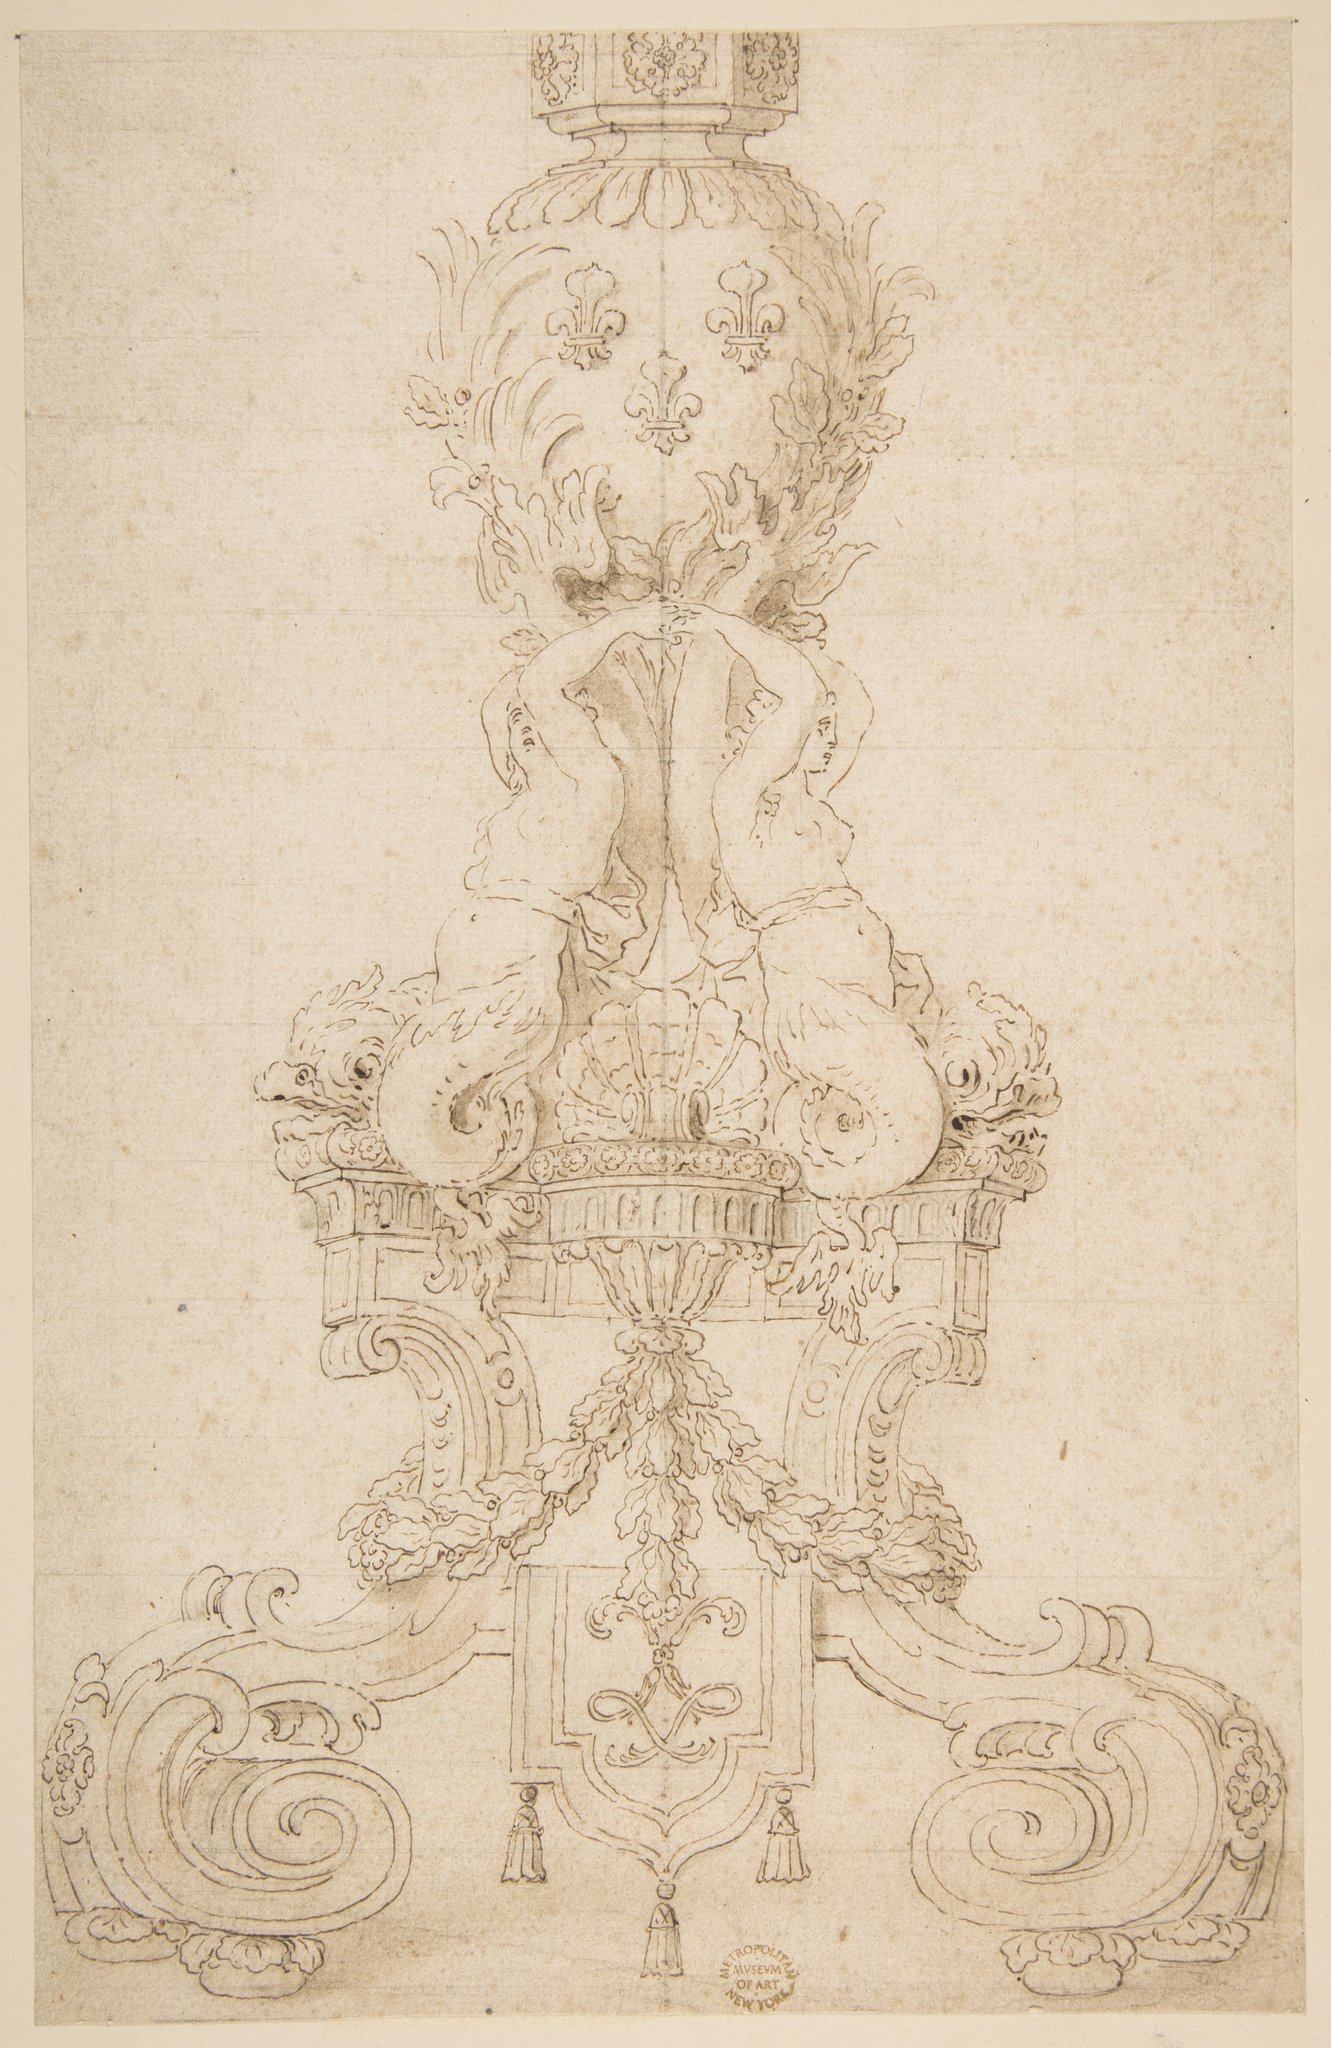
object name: drawing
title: Design for a Candelabrum with the Monogram of Louis XIV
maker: anonymous, french, 17th century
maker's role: artist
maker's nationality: french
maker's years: 1600-1700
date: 1601-1700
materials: ink, paper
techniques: pen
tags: louis xiv,dolphins,candelabra